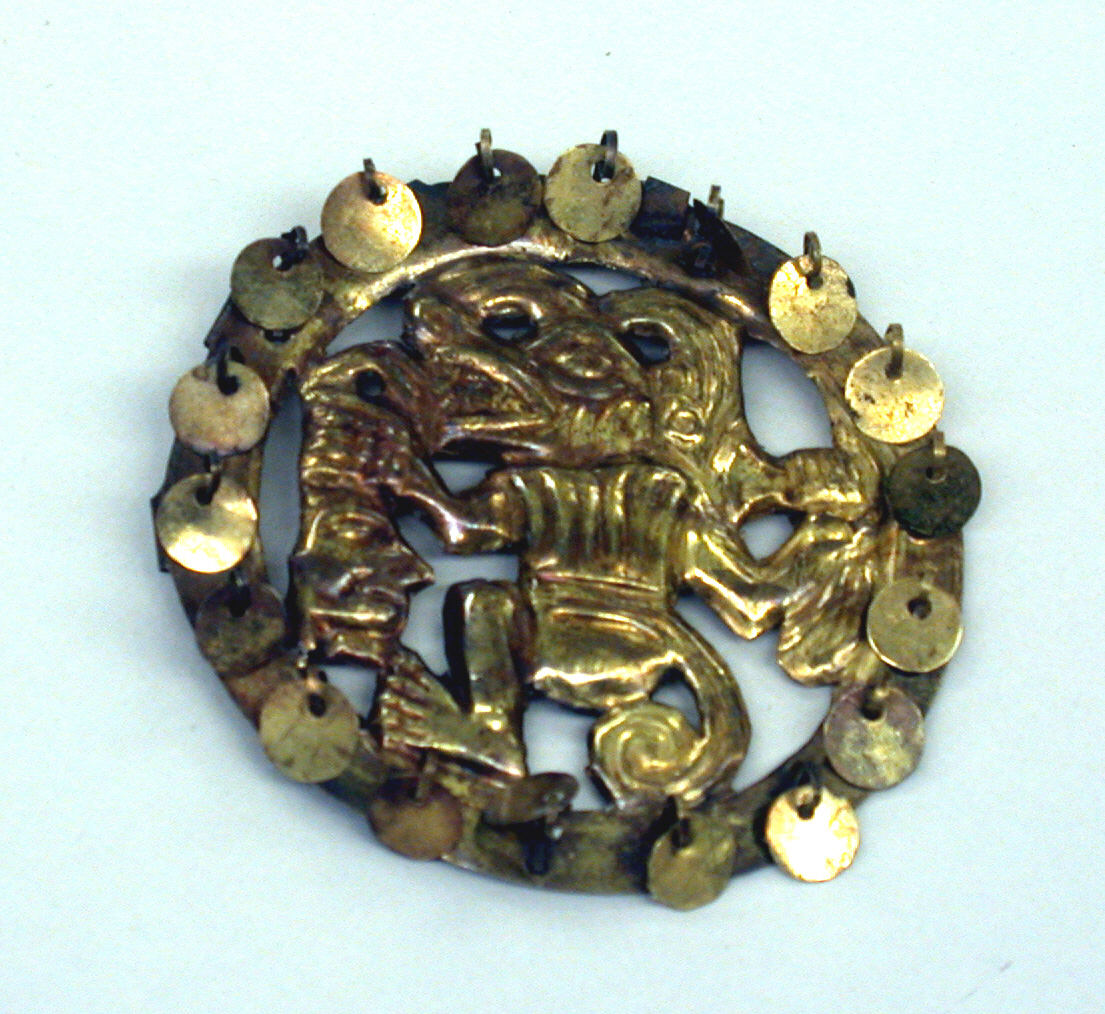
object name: earflare frontal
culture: moche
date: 501-700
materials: gold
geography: peru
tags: heads,mythical creatures